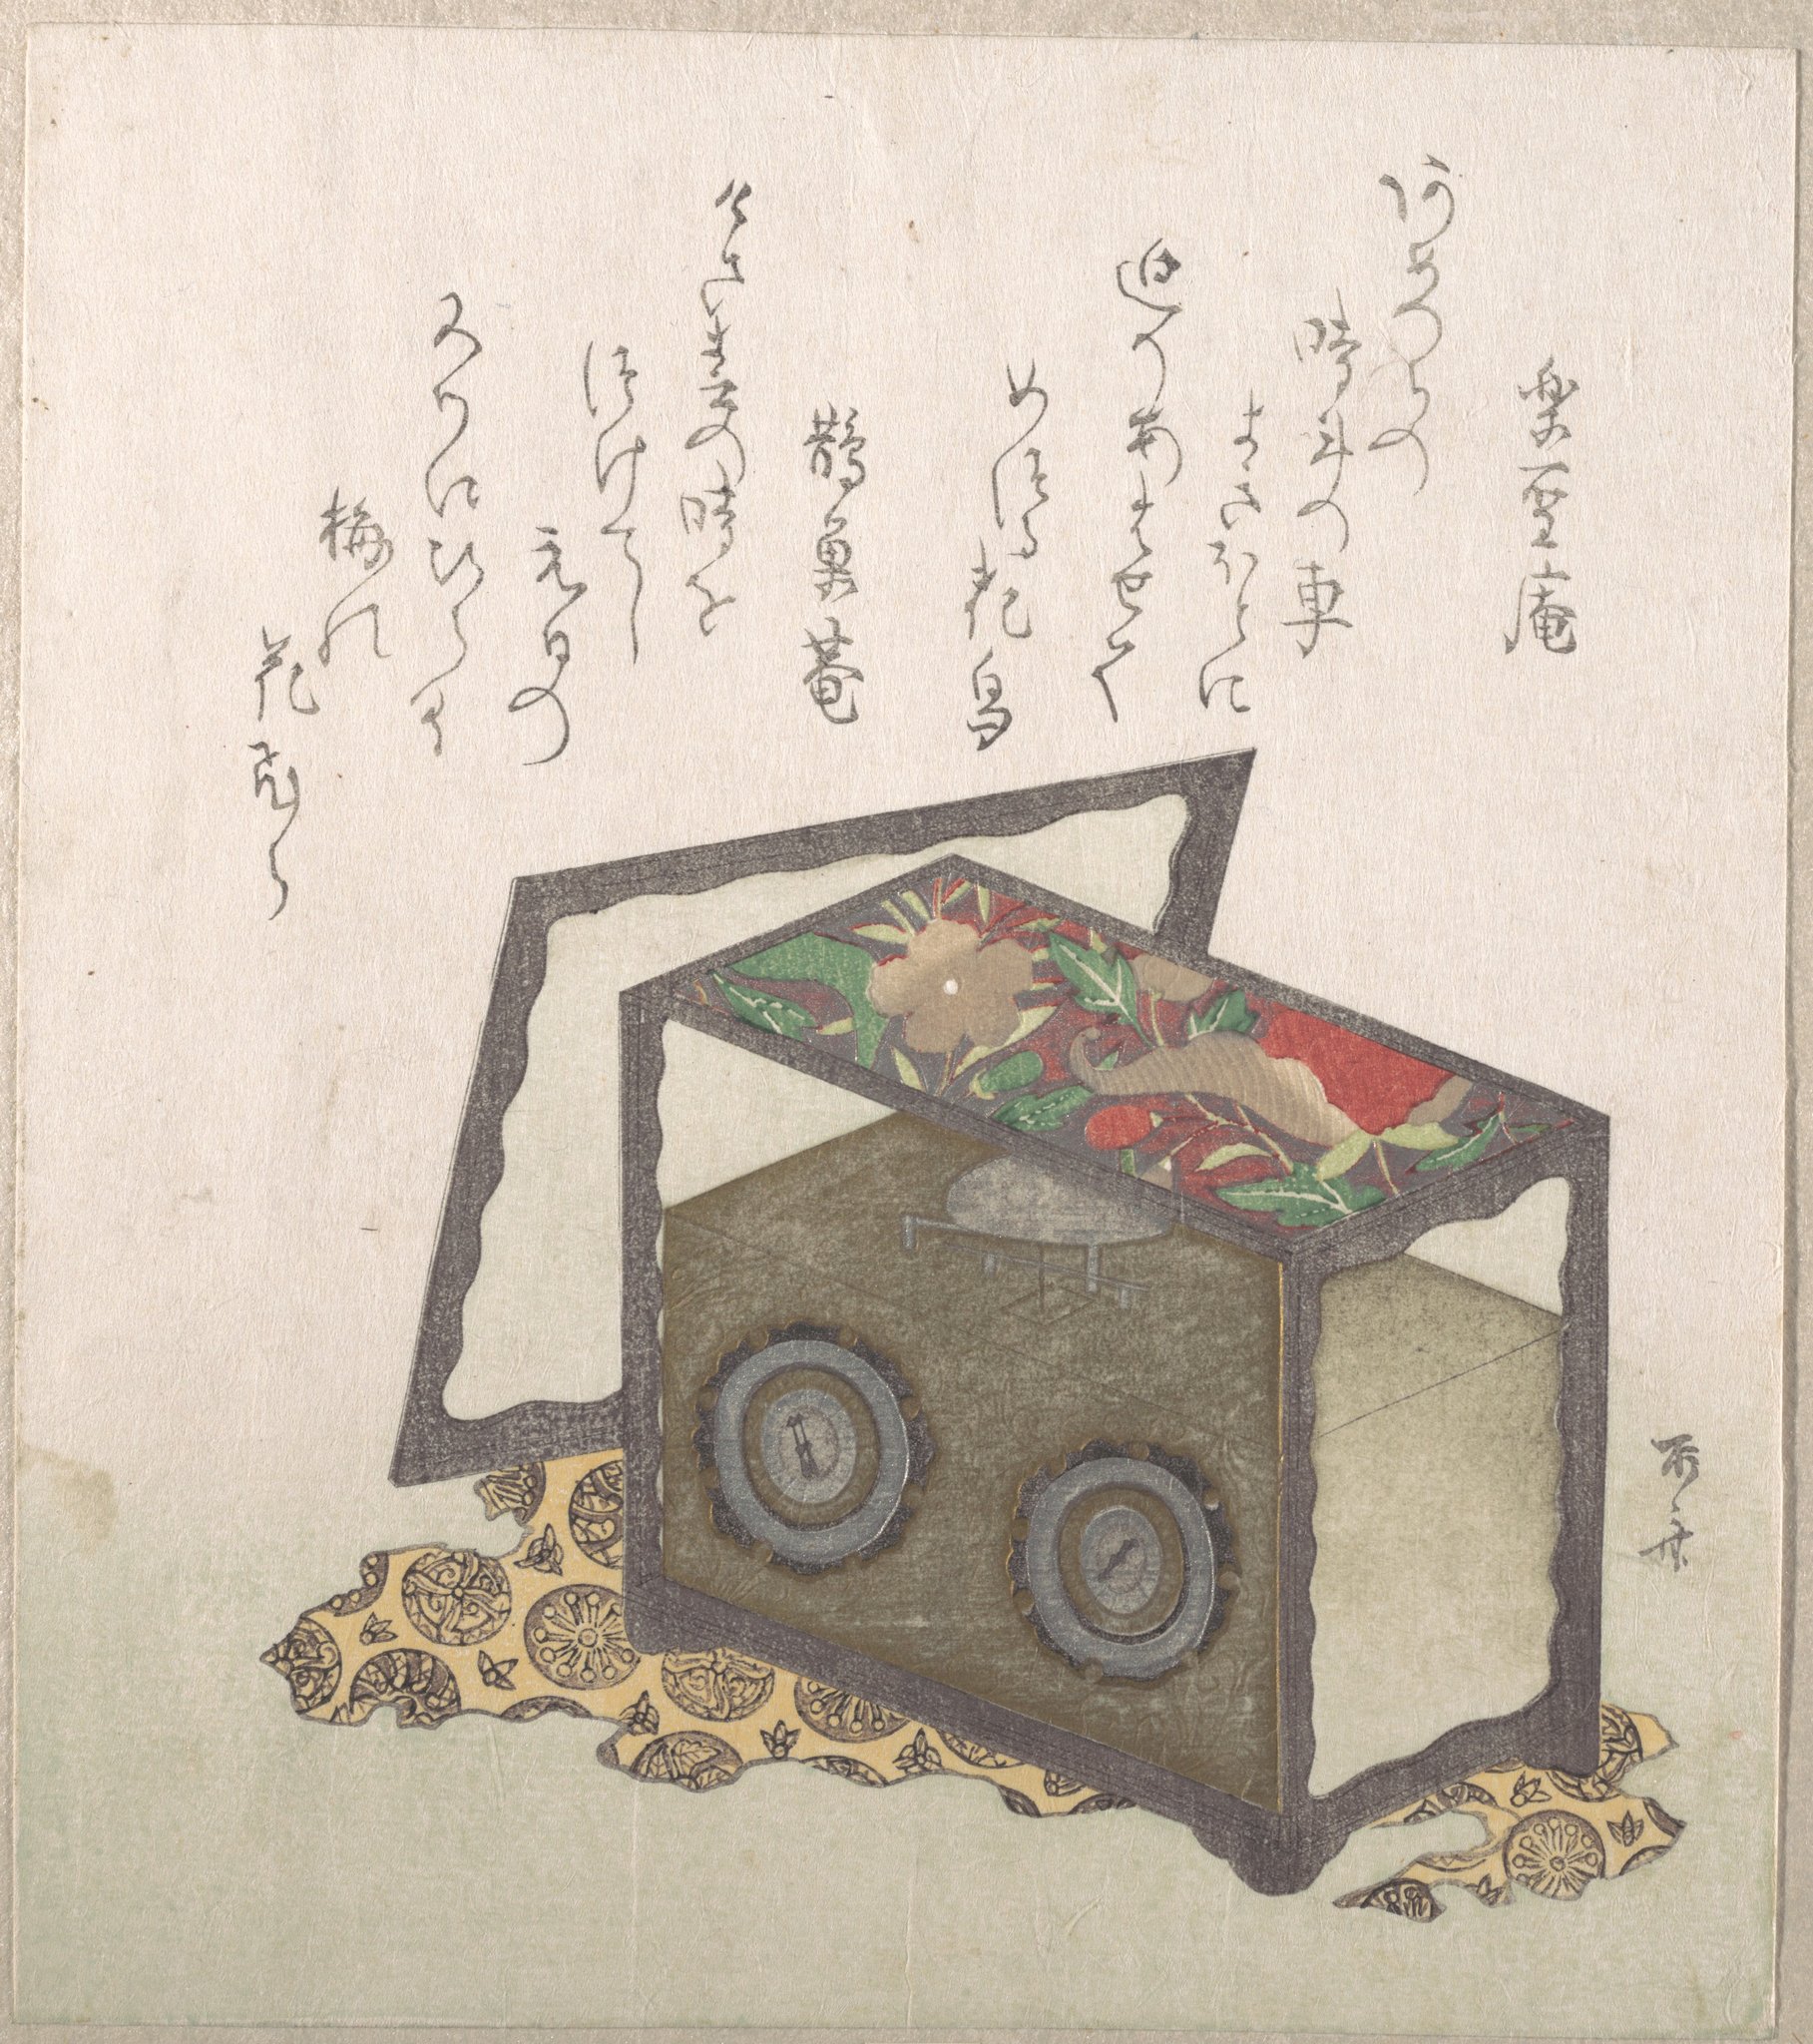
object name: print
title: Clock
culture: japanese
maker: ryūryūkyo shinsai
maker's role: artist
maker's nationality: japanese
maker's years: 1799-1823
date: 1801-1900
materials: ink, paper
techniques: surimono, woodblock print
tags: flowers,clocks